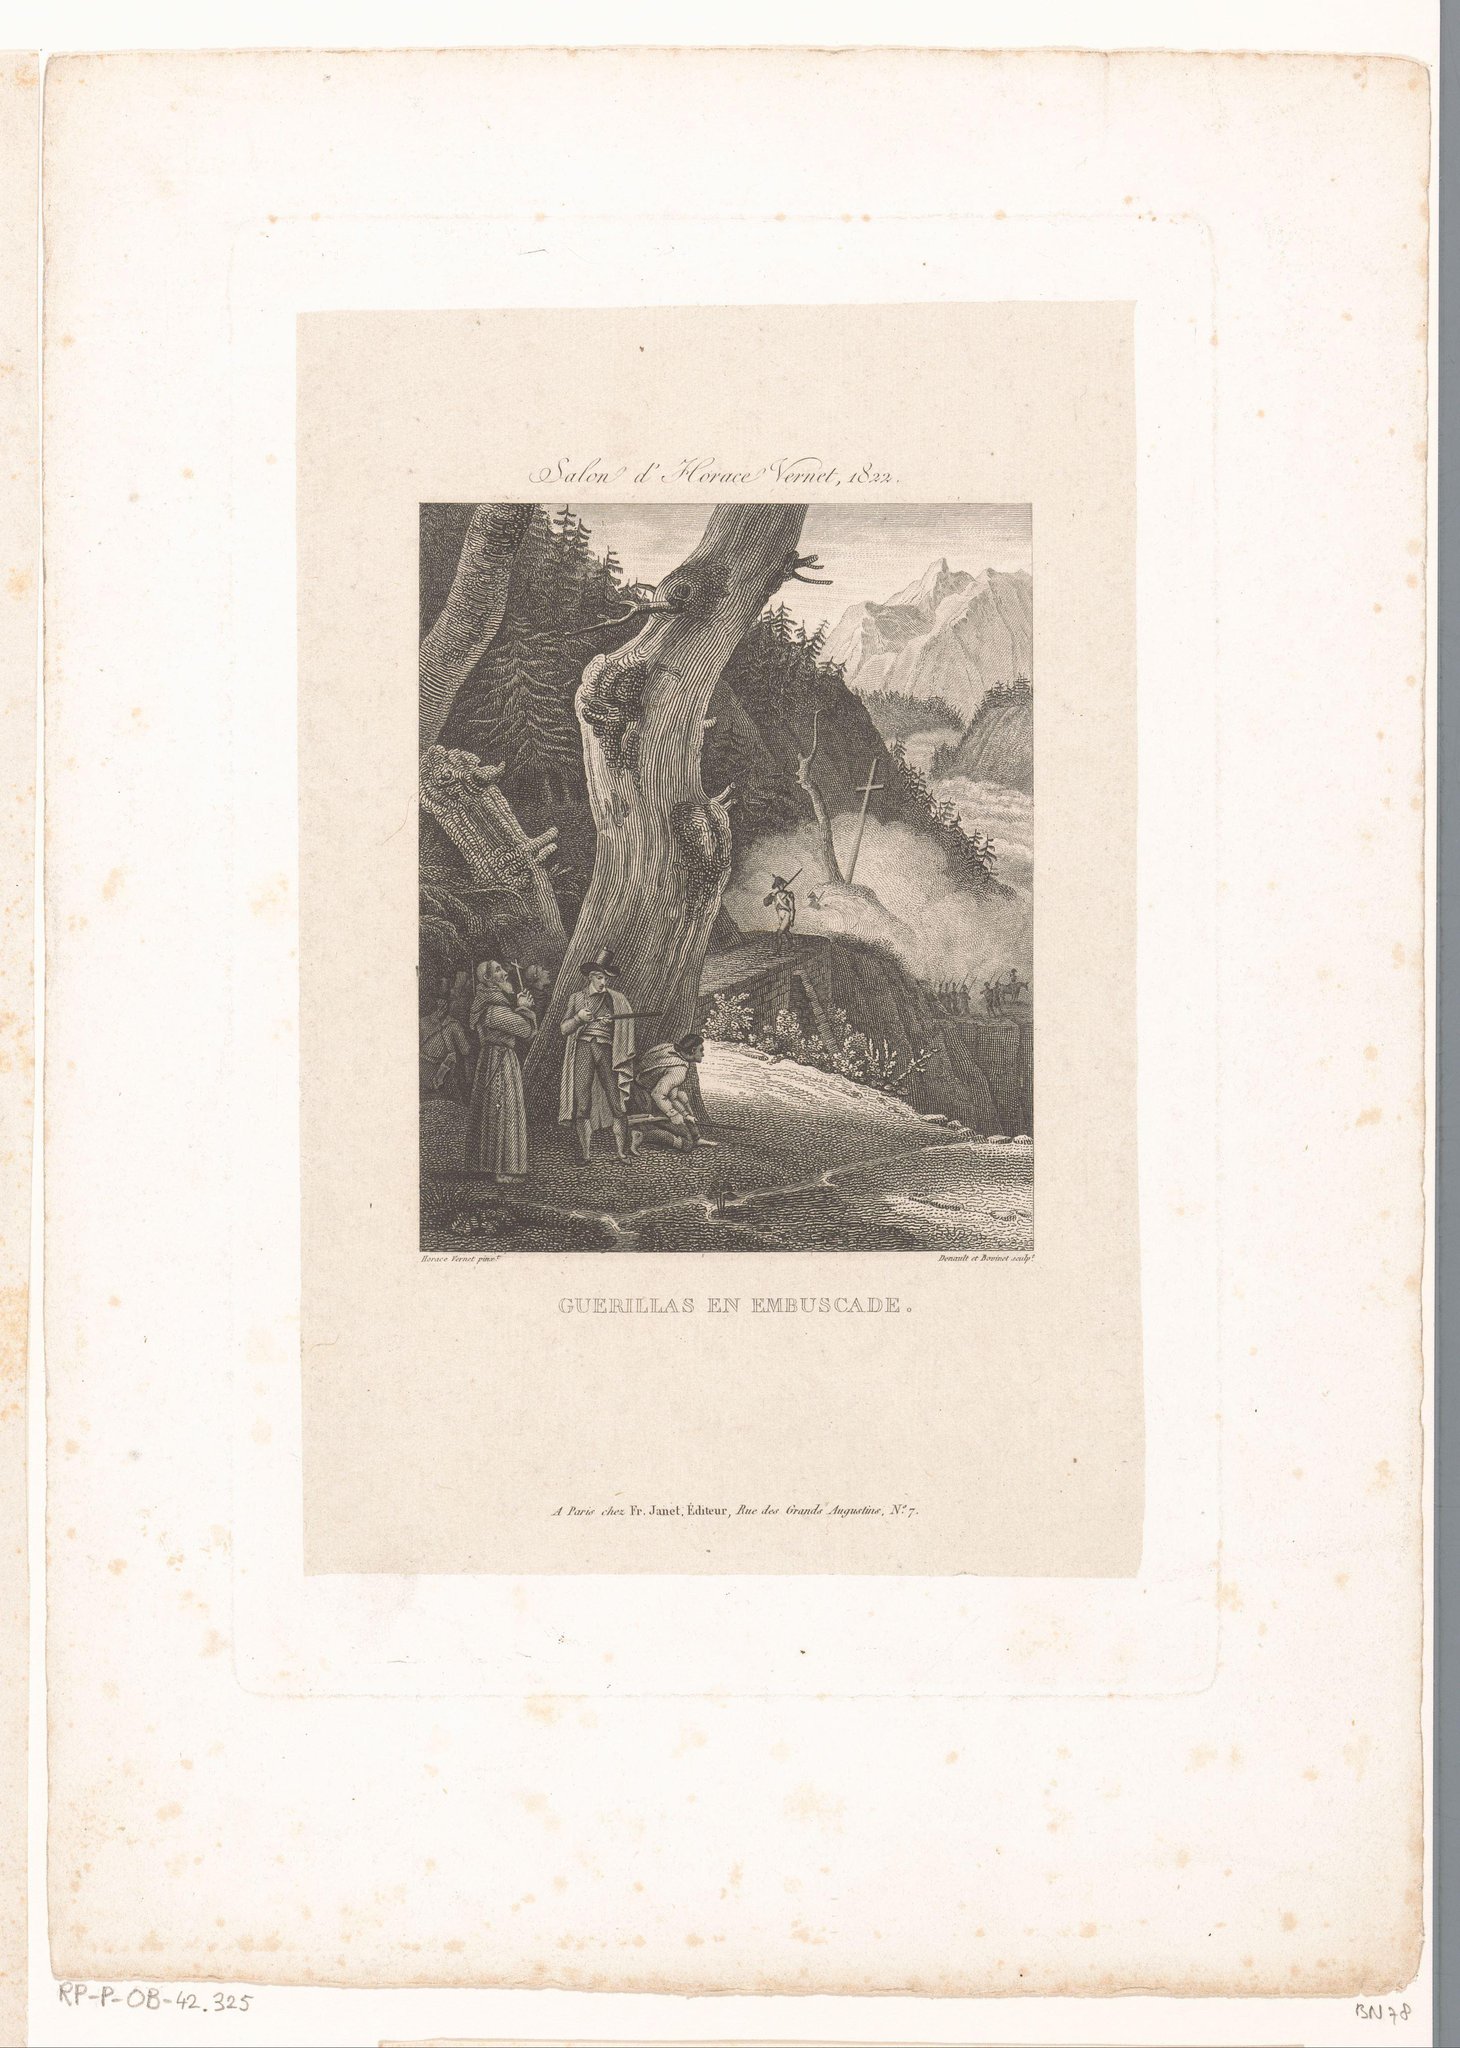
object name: print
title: Salon d'Horace Vernet, 1822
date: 1822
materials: paper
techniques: engraving, etching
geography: paris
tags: guerilla warfare, firearms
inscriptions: collector's mark: Lugt 2228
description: Maakt deel uit van een serie van vijf prenten, getiteld 'Salon d'Horace Vernet, 1822'.